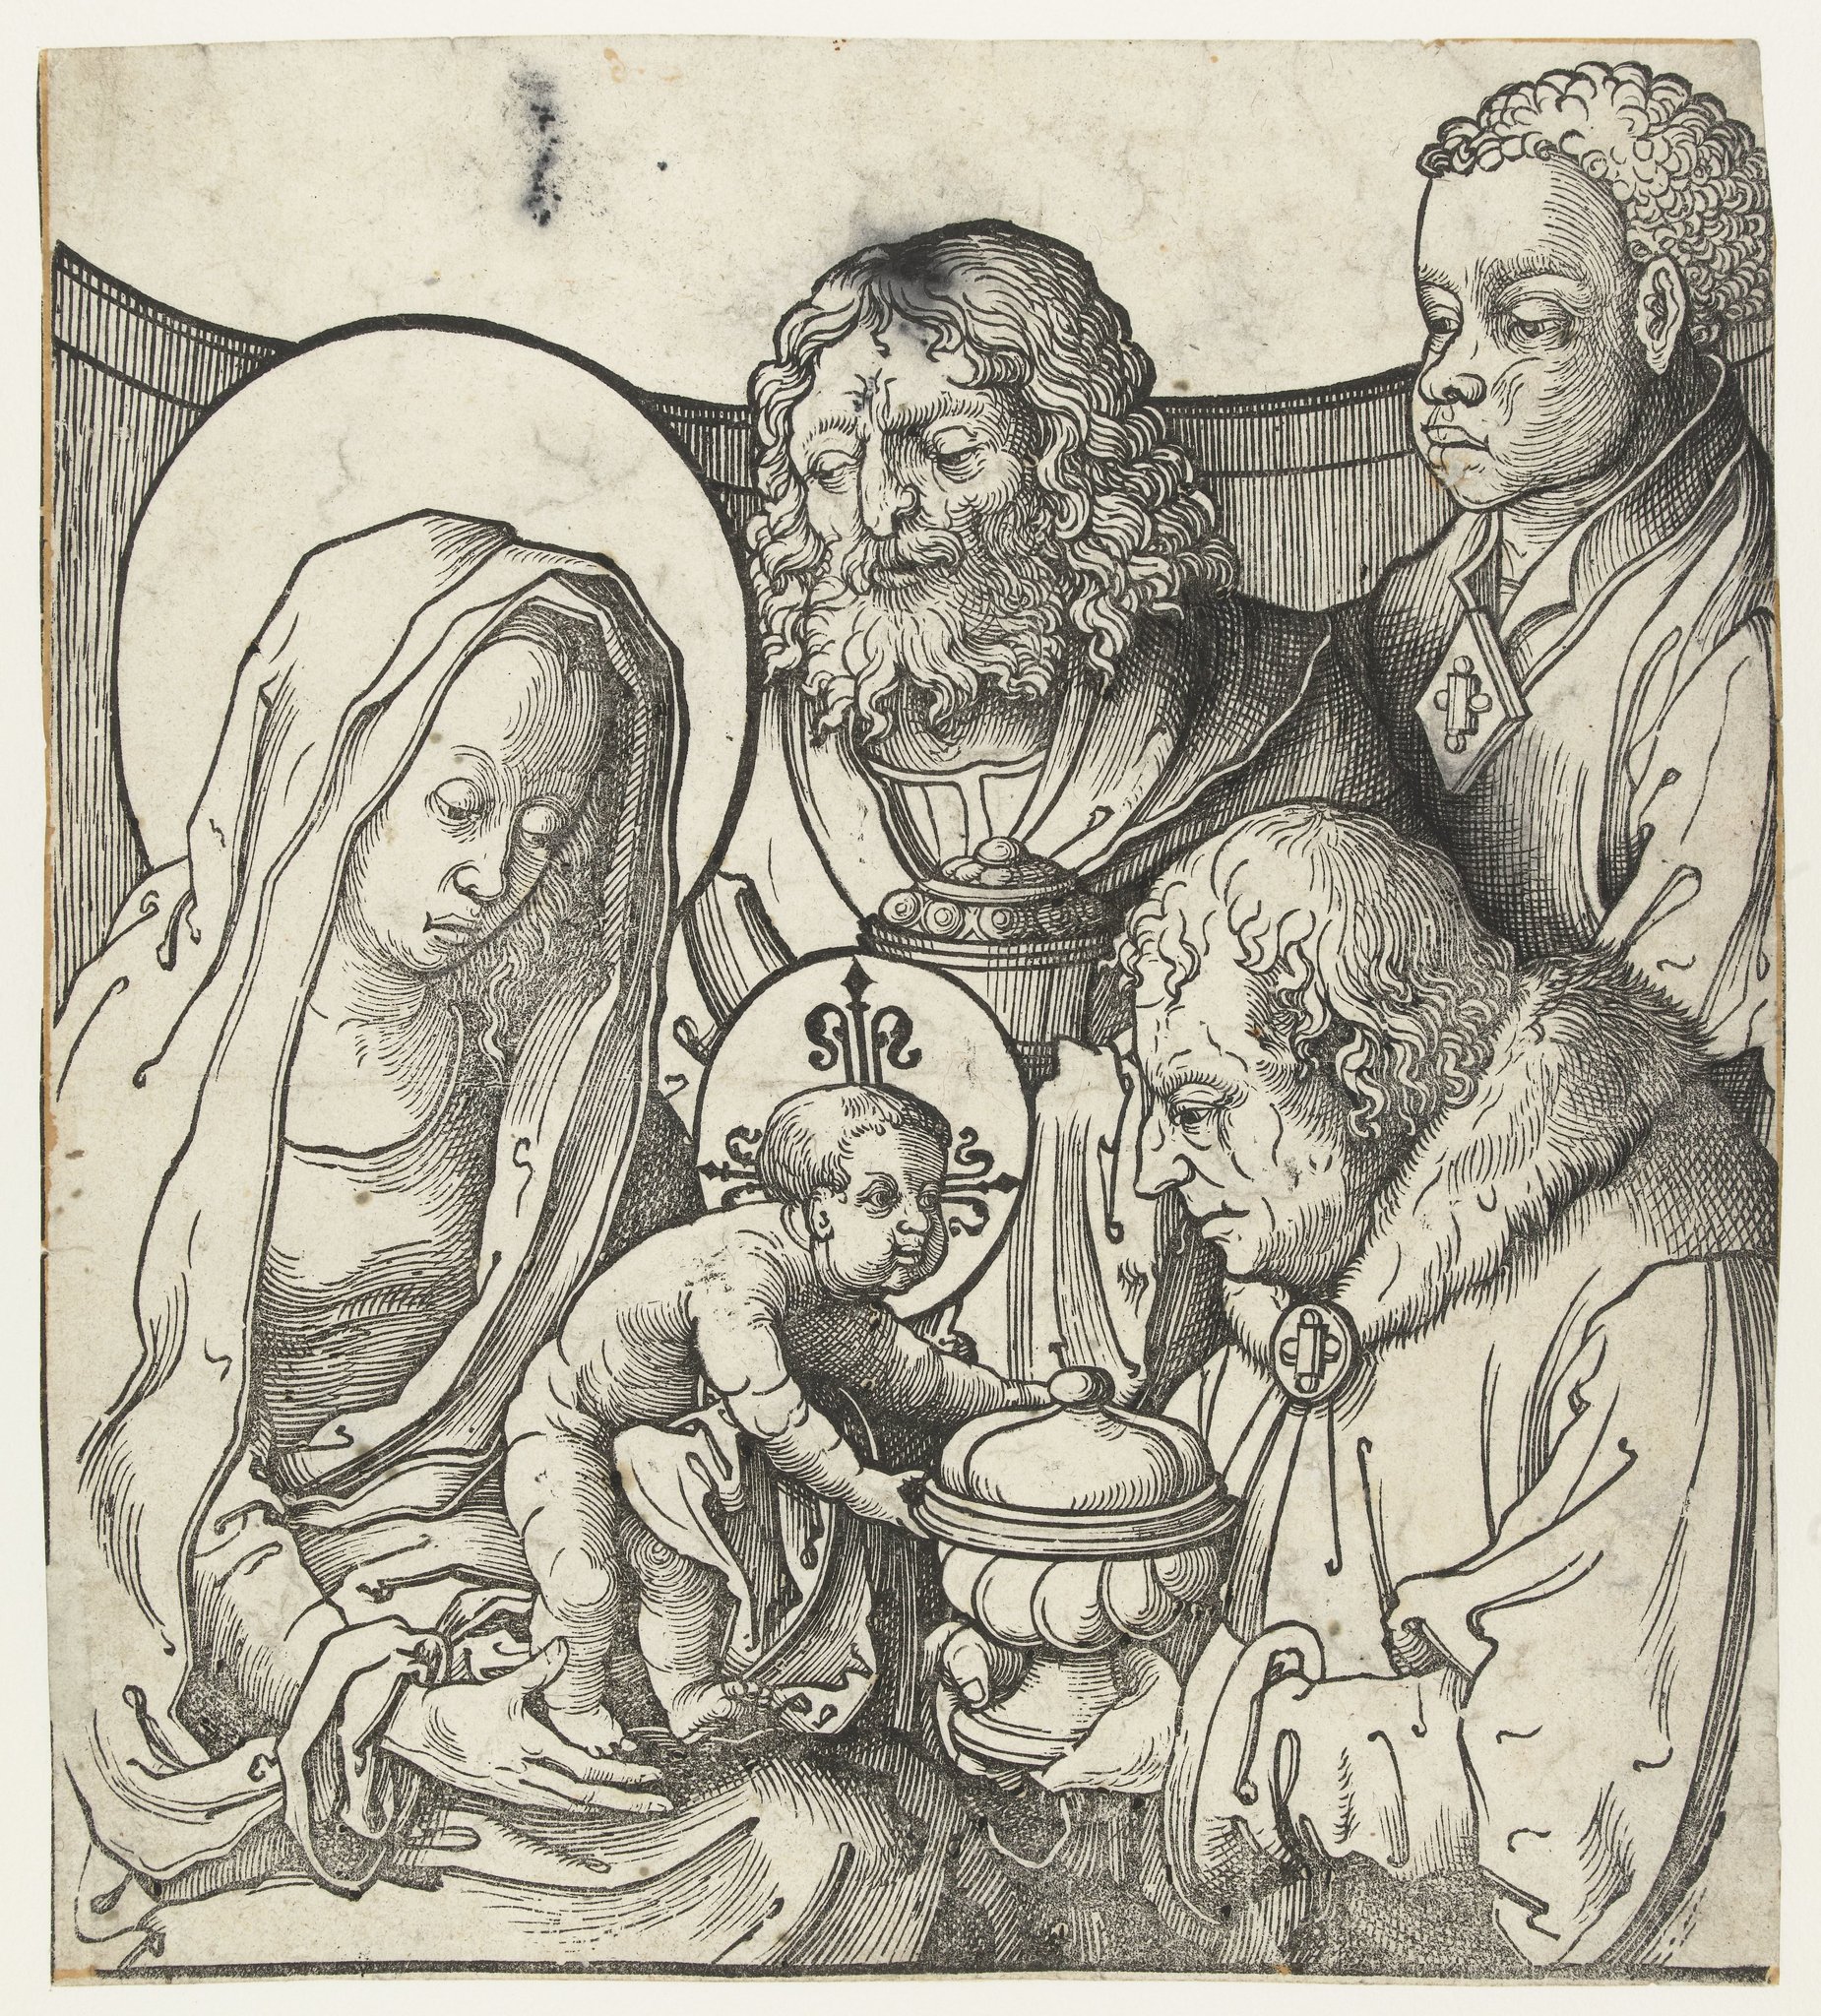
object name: print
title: De aanbidding der koningen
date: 1513-1583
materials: paper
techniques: retouching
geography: low countries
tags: adoration of the kings: the wise men present their gifts to the christ-child (gold, frankincense and myrrh)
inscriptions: collector's mark: Lugt 700, collector's mark: Lugt 2228a, collector's mark: Lugt 240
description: De aanbidding van het Christuskind door de drie koningen. Gedrukt van houtblok met houtworm, prent opgewerkt met penseel.